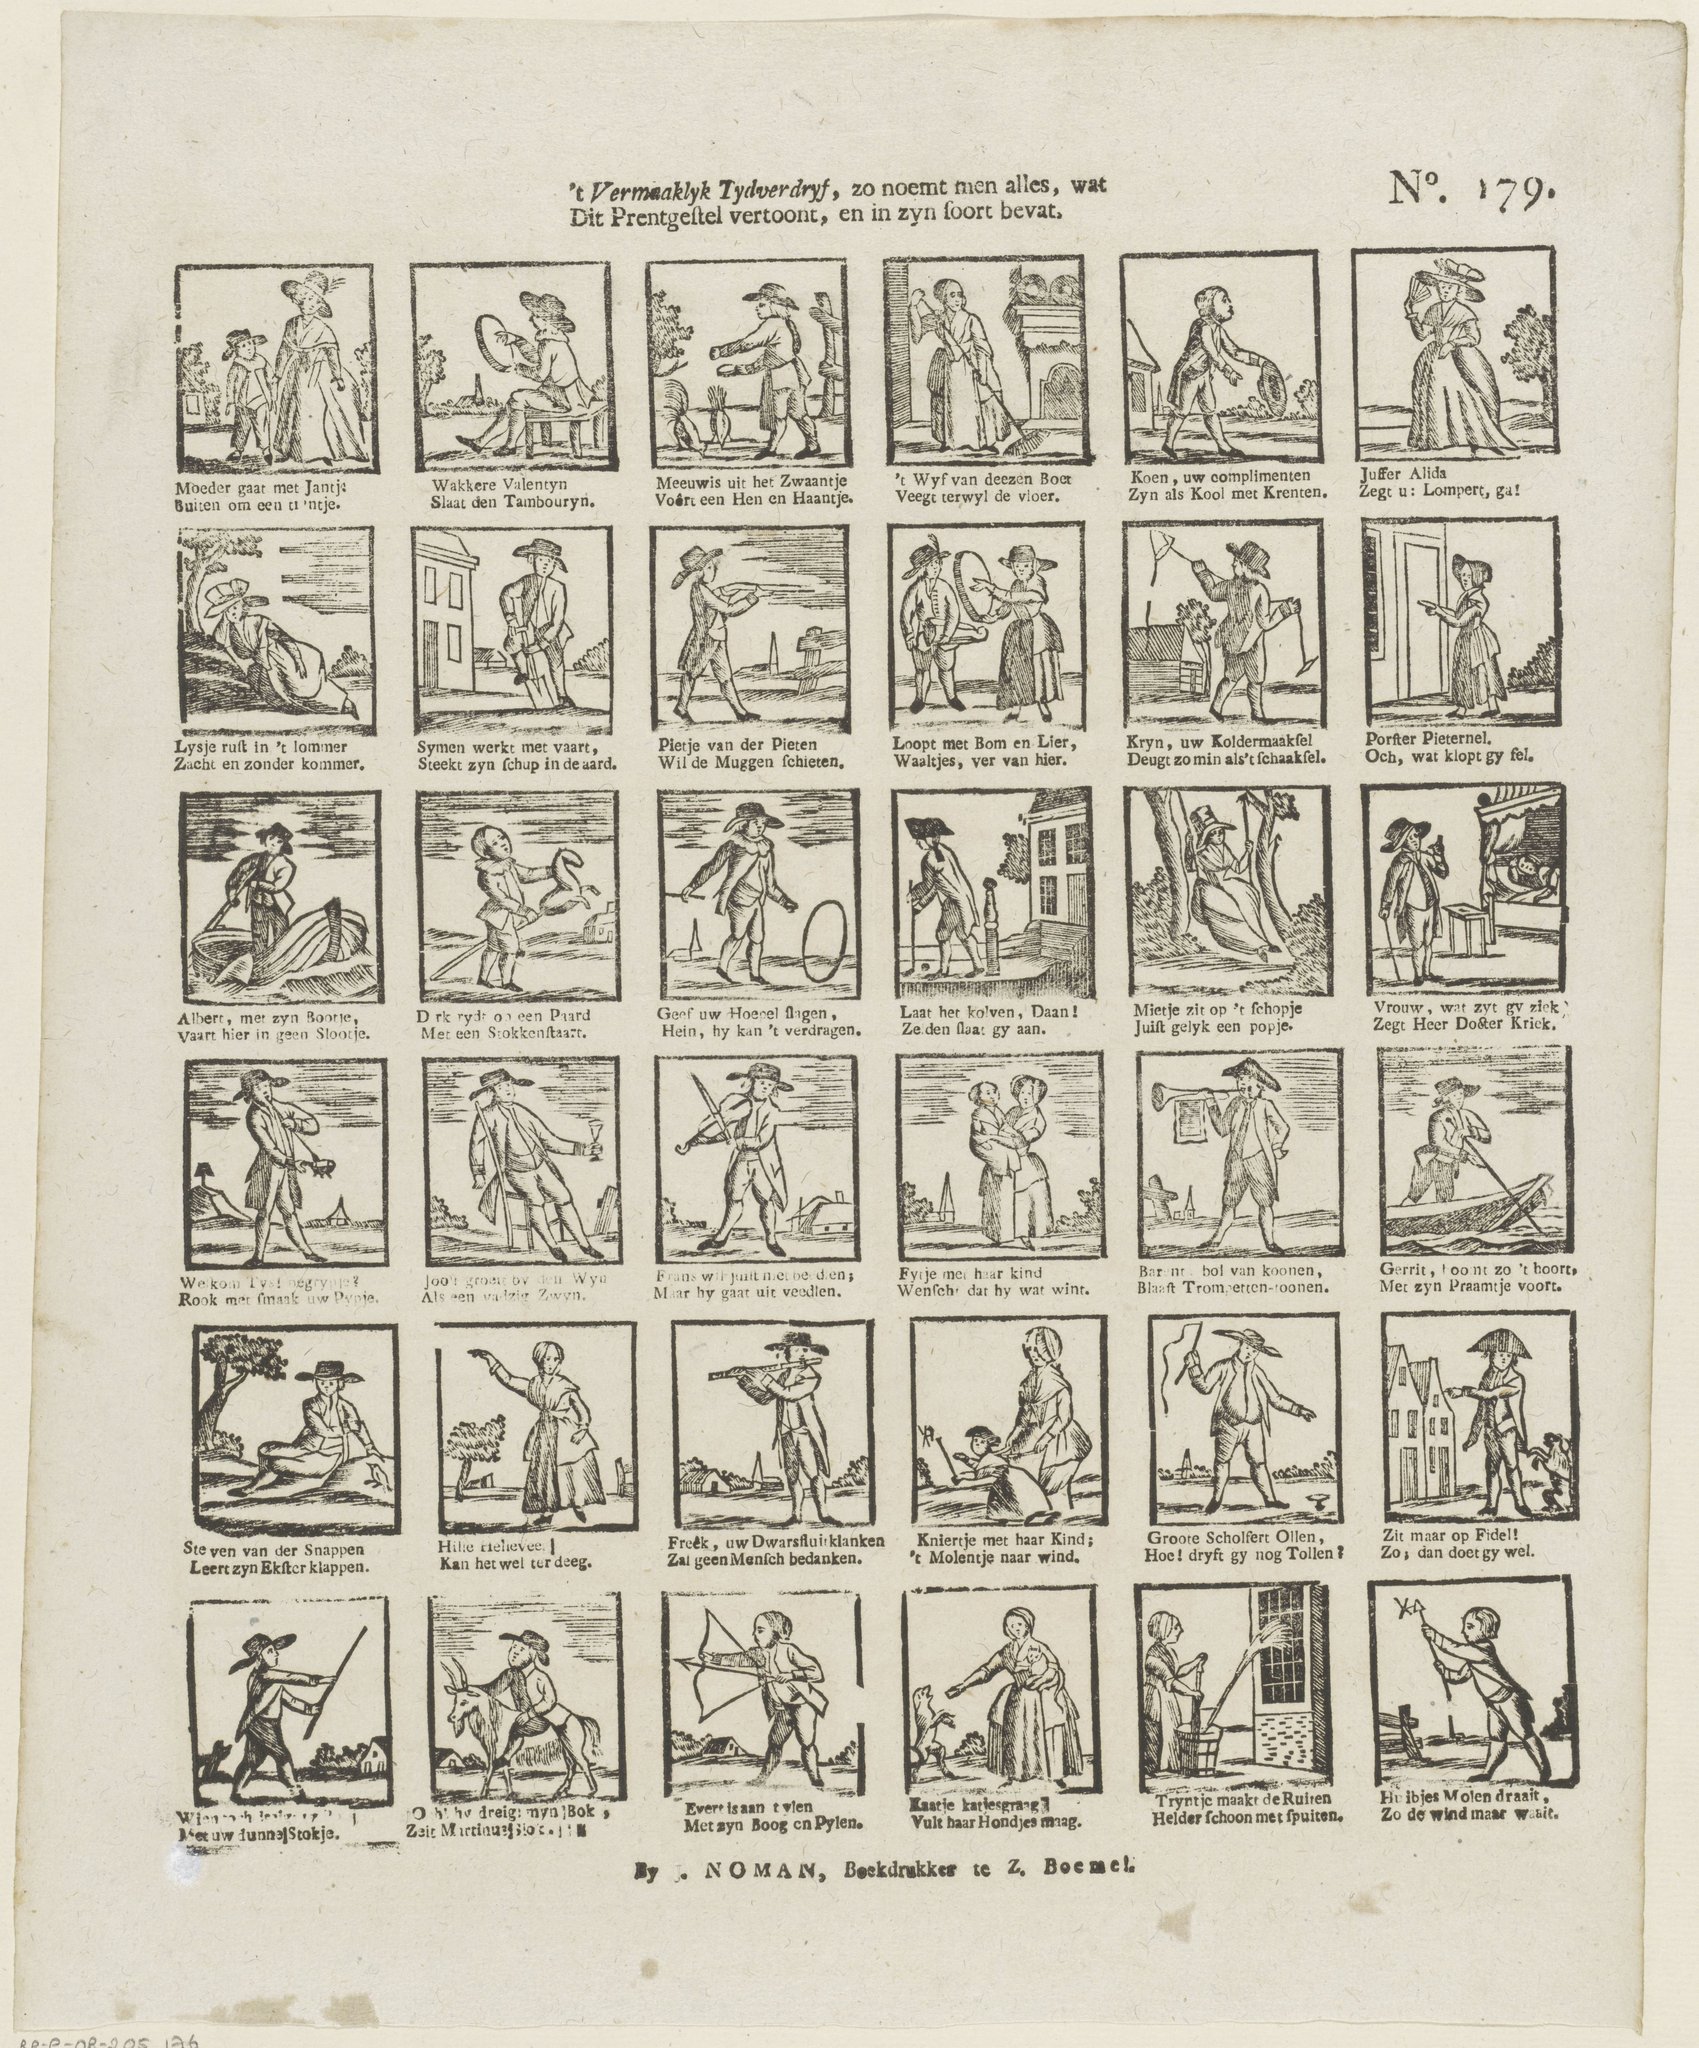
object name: print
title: 't Vermaaklyk tydverdryf, zo noemt men alles, wat / Dit prentgestel vertoont, en in zyn soort bevat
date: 1806-1830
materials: paper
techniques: letterpress printing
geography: zaltbommel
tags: children's games and plays, human types, games using special objects (marbles, top, hoop, etc.)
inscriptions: collector's mark: Lugt 2760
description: Blad met 36 voorstellingen van verschillende figuren, bezigheden en kinderspelen. Onder elke afbeelding een tweeregelig vers. Genummerd rechtsboven: No. 179.